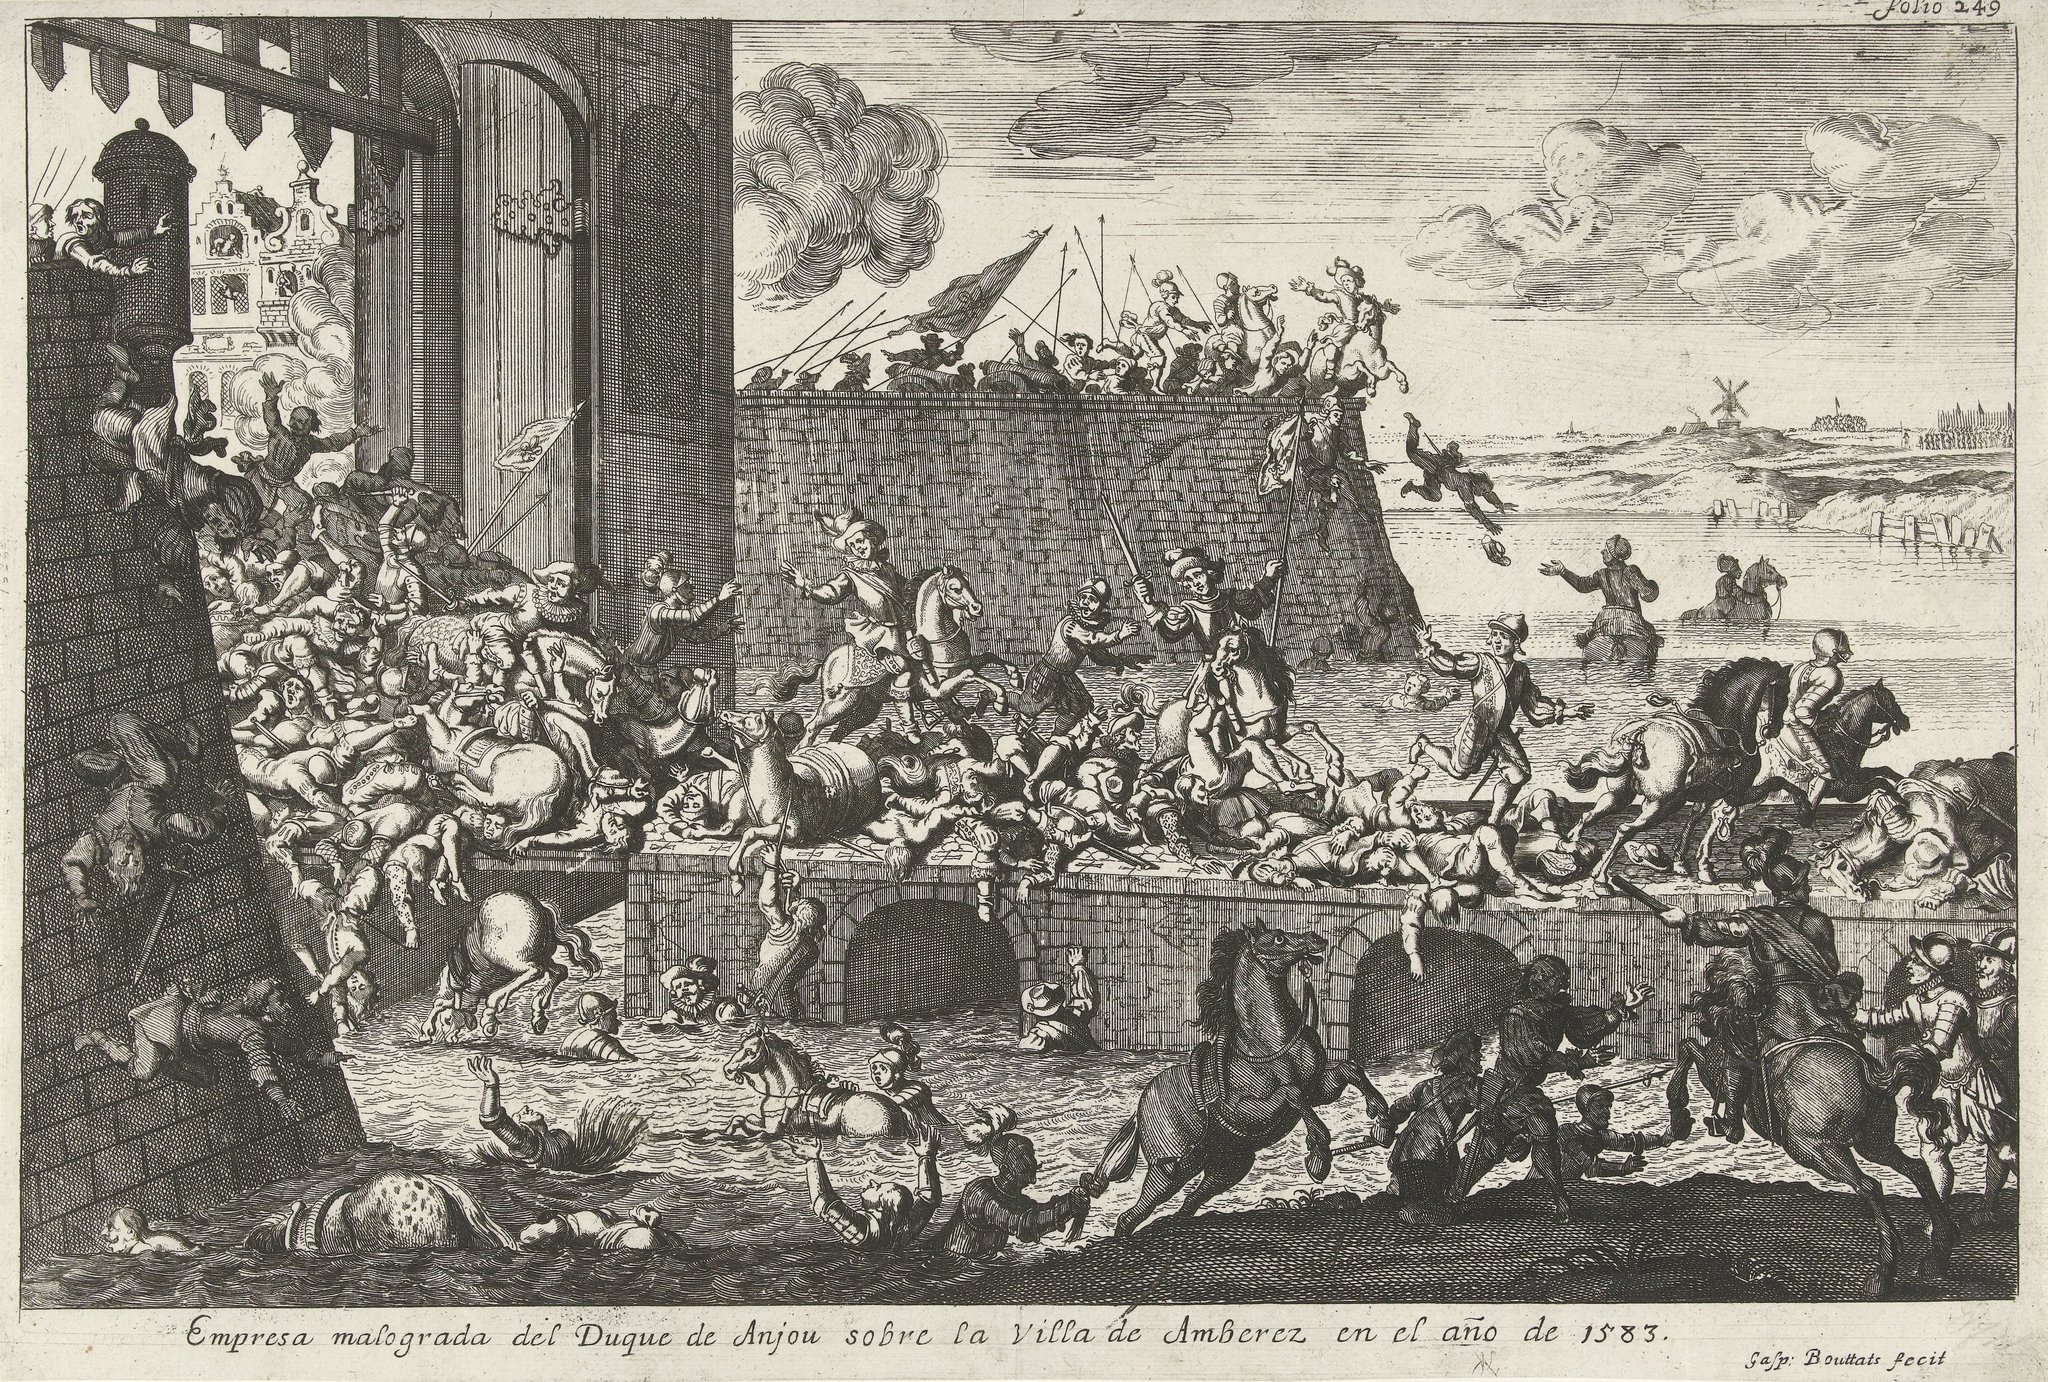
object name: print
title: De Franse Furie te Antwerpen, 1583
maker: gaspar bouttats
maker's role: print maker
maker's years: 1640-1695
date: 1680-1695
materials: paper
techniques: etching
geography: southern netherlands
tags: paris, françois-hercule de valois (hertog van anjou), counter-attack, plundering ~ soldiers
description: De Franse Furie te Antwerpen, 17 januari 1583. De plunderende Franse soldaten van de hertog van Anjou worden bij de Kipdorppoort uit de stad gejaagd.